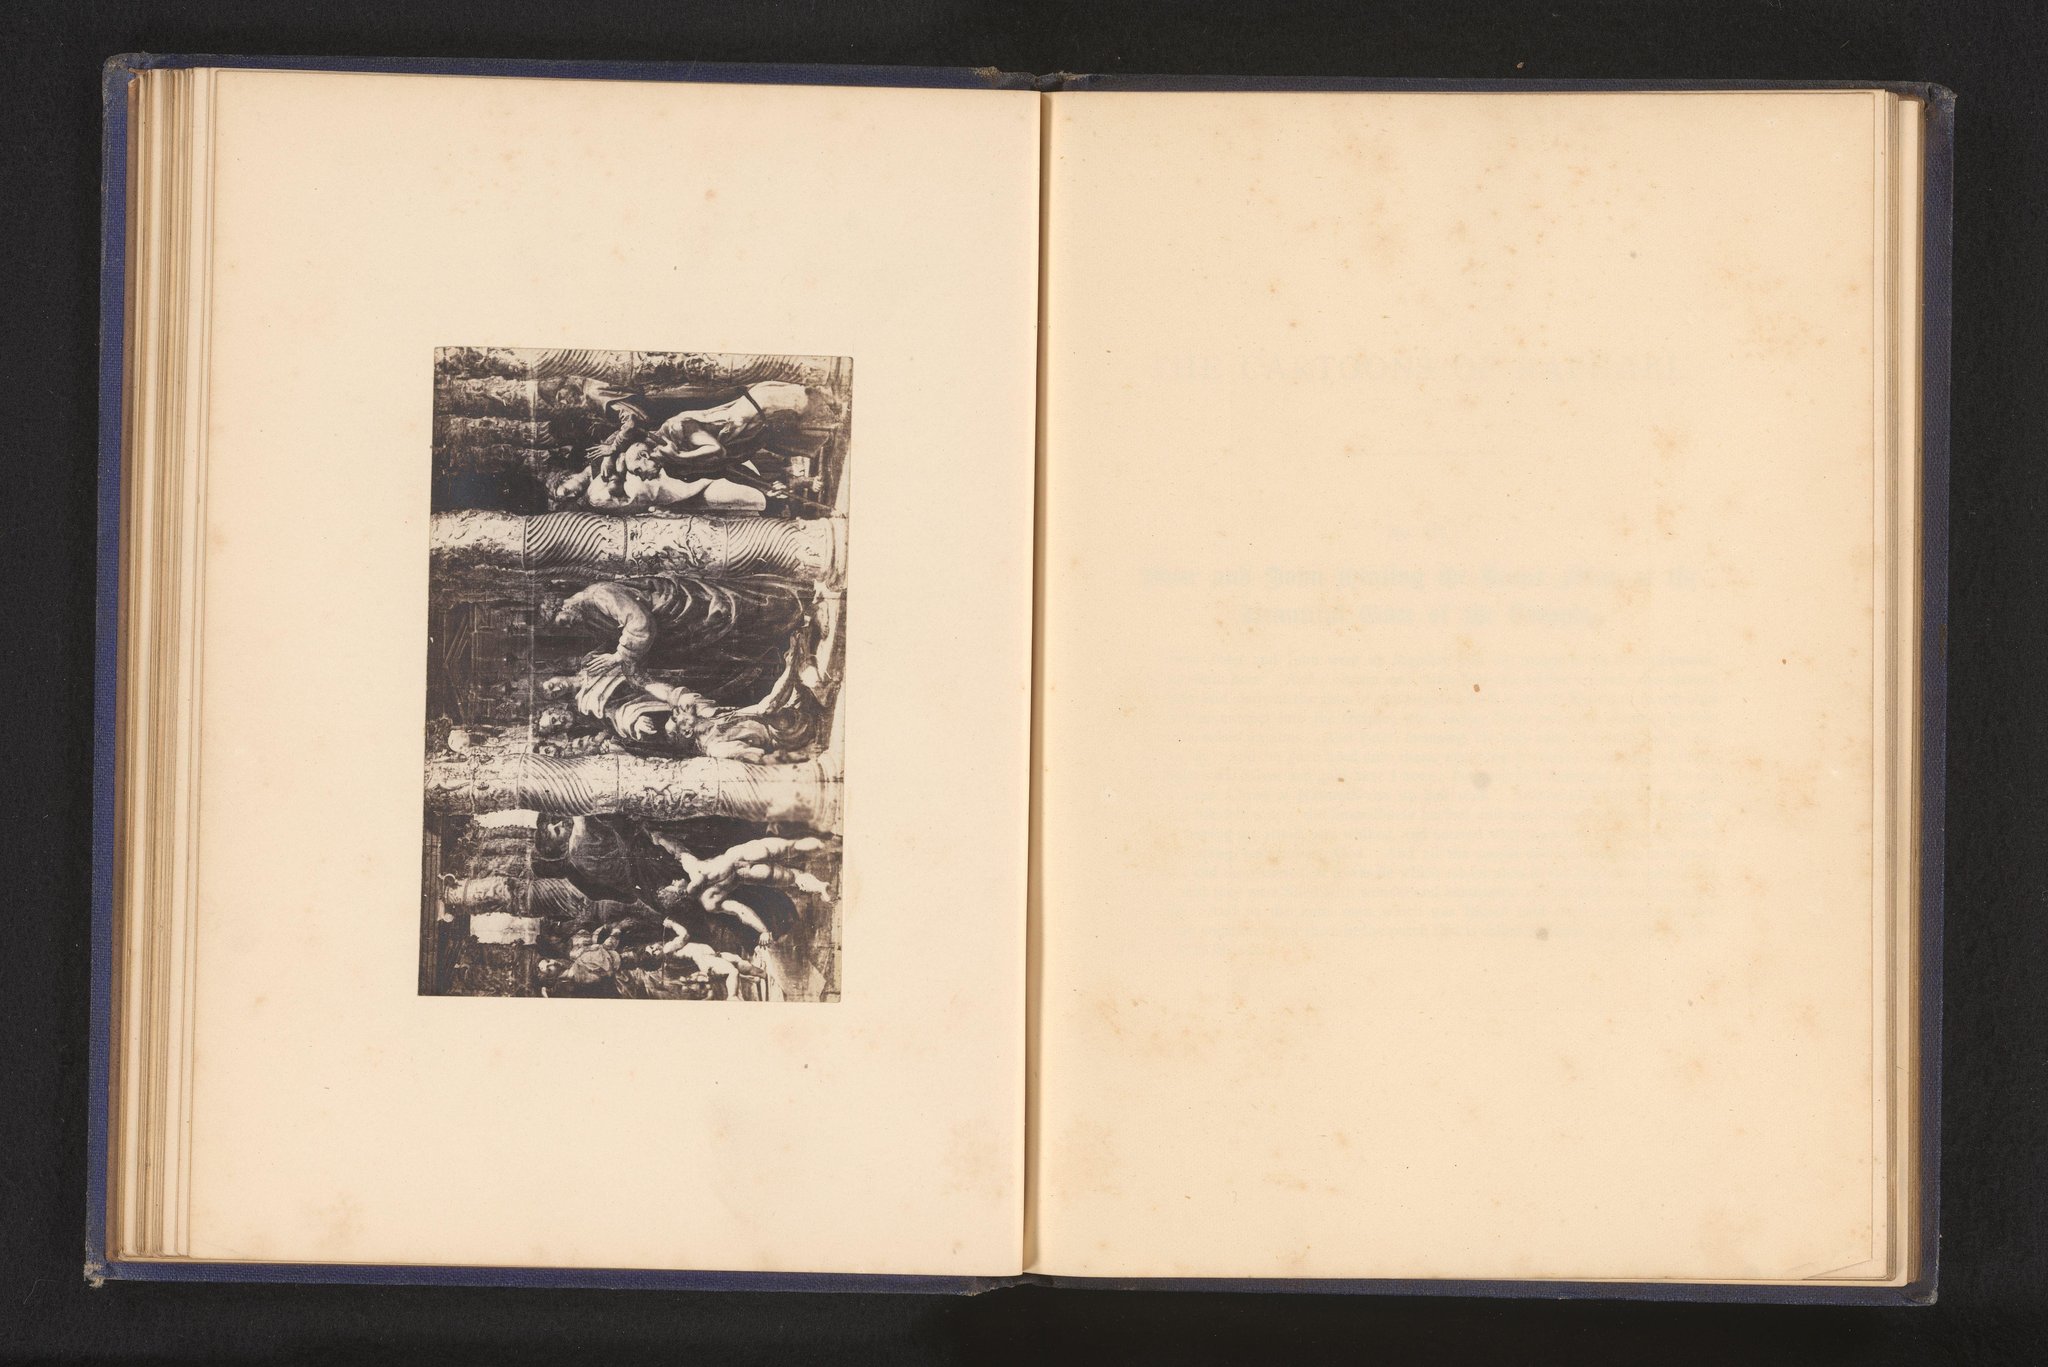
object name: page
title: Fotoreproductie van de ontwerptekening Peter and John healing the lame man at the beautiful gate of the temple door Rafaël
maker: Anonymous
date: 1863-1868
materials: paper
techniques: albumen print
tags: drawing, sketch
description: Foto op tweede ongenummerde pagina na pagina 26.